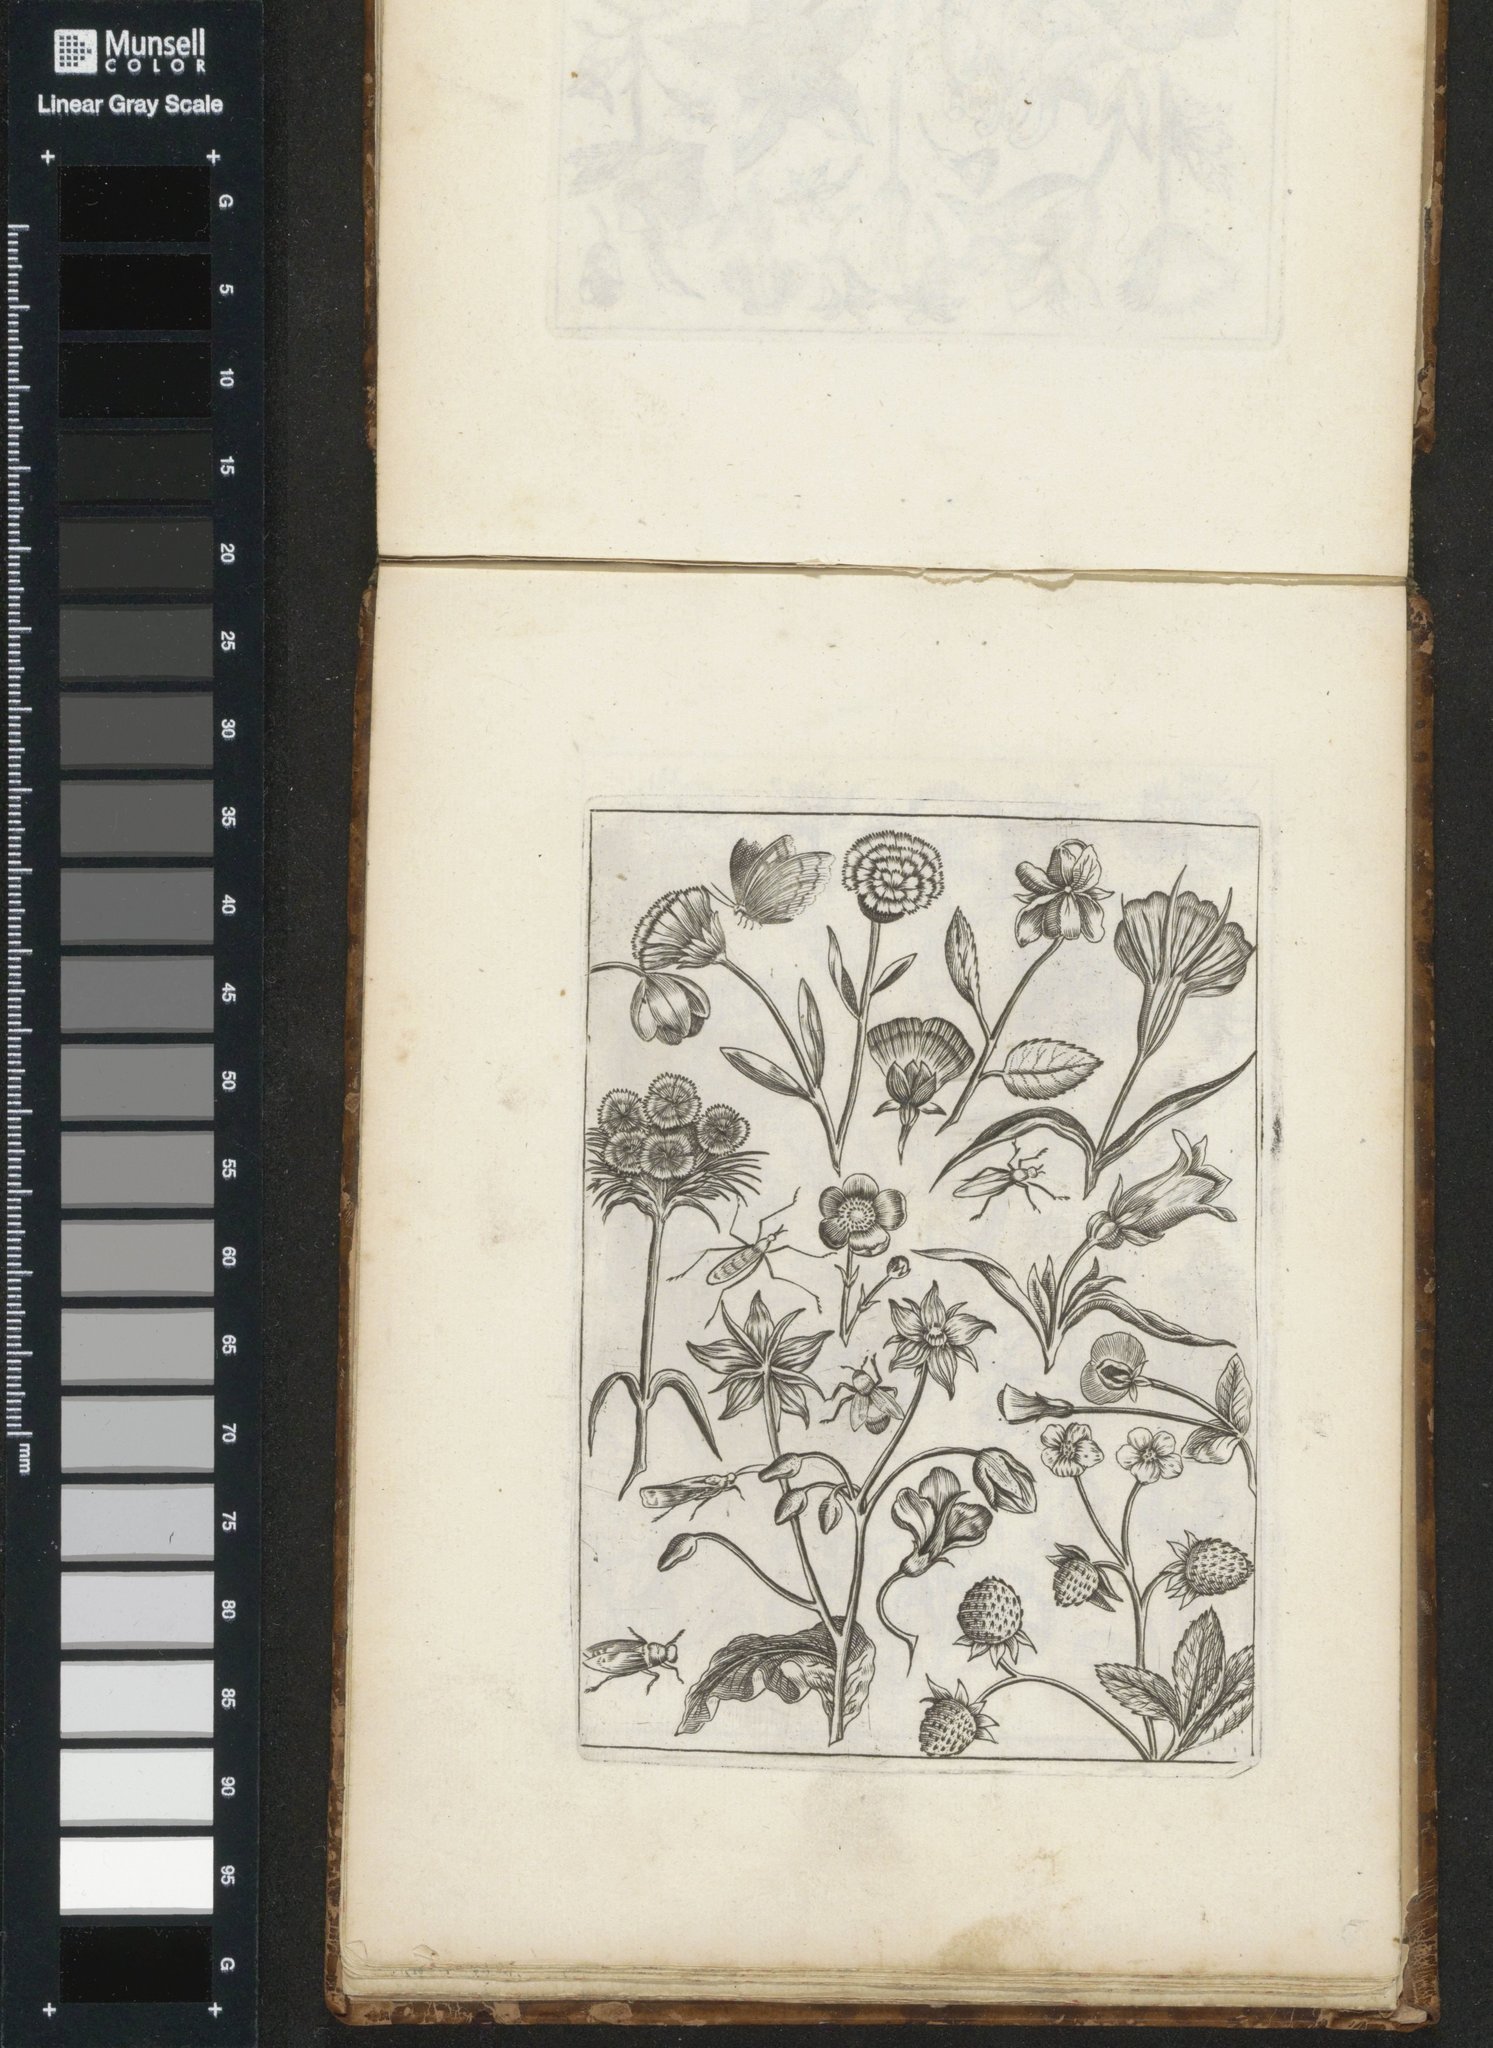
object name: album leaf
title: Bloemen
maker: Anonymous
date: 1635-1660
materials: paper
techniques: engraving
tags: flowers, plants and herbs: strawberry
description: Verschillende bloemen op een blad, onder andere duizendschoon en een bloeiende aardbeiplant. Deze prent maakt deel uit van een album.